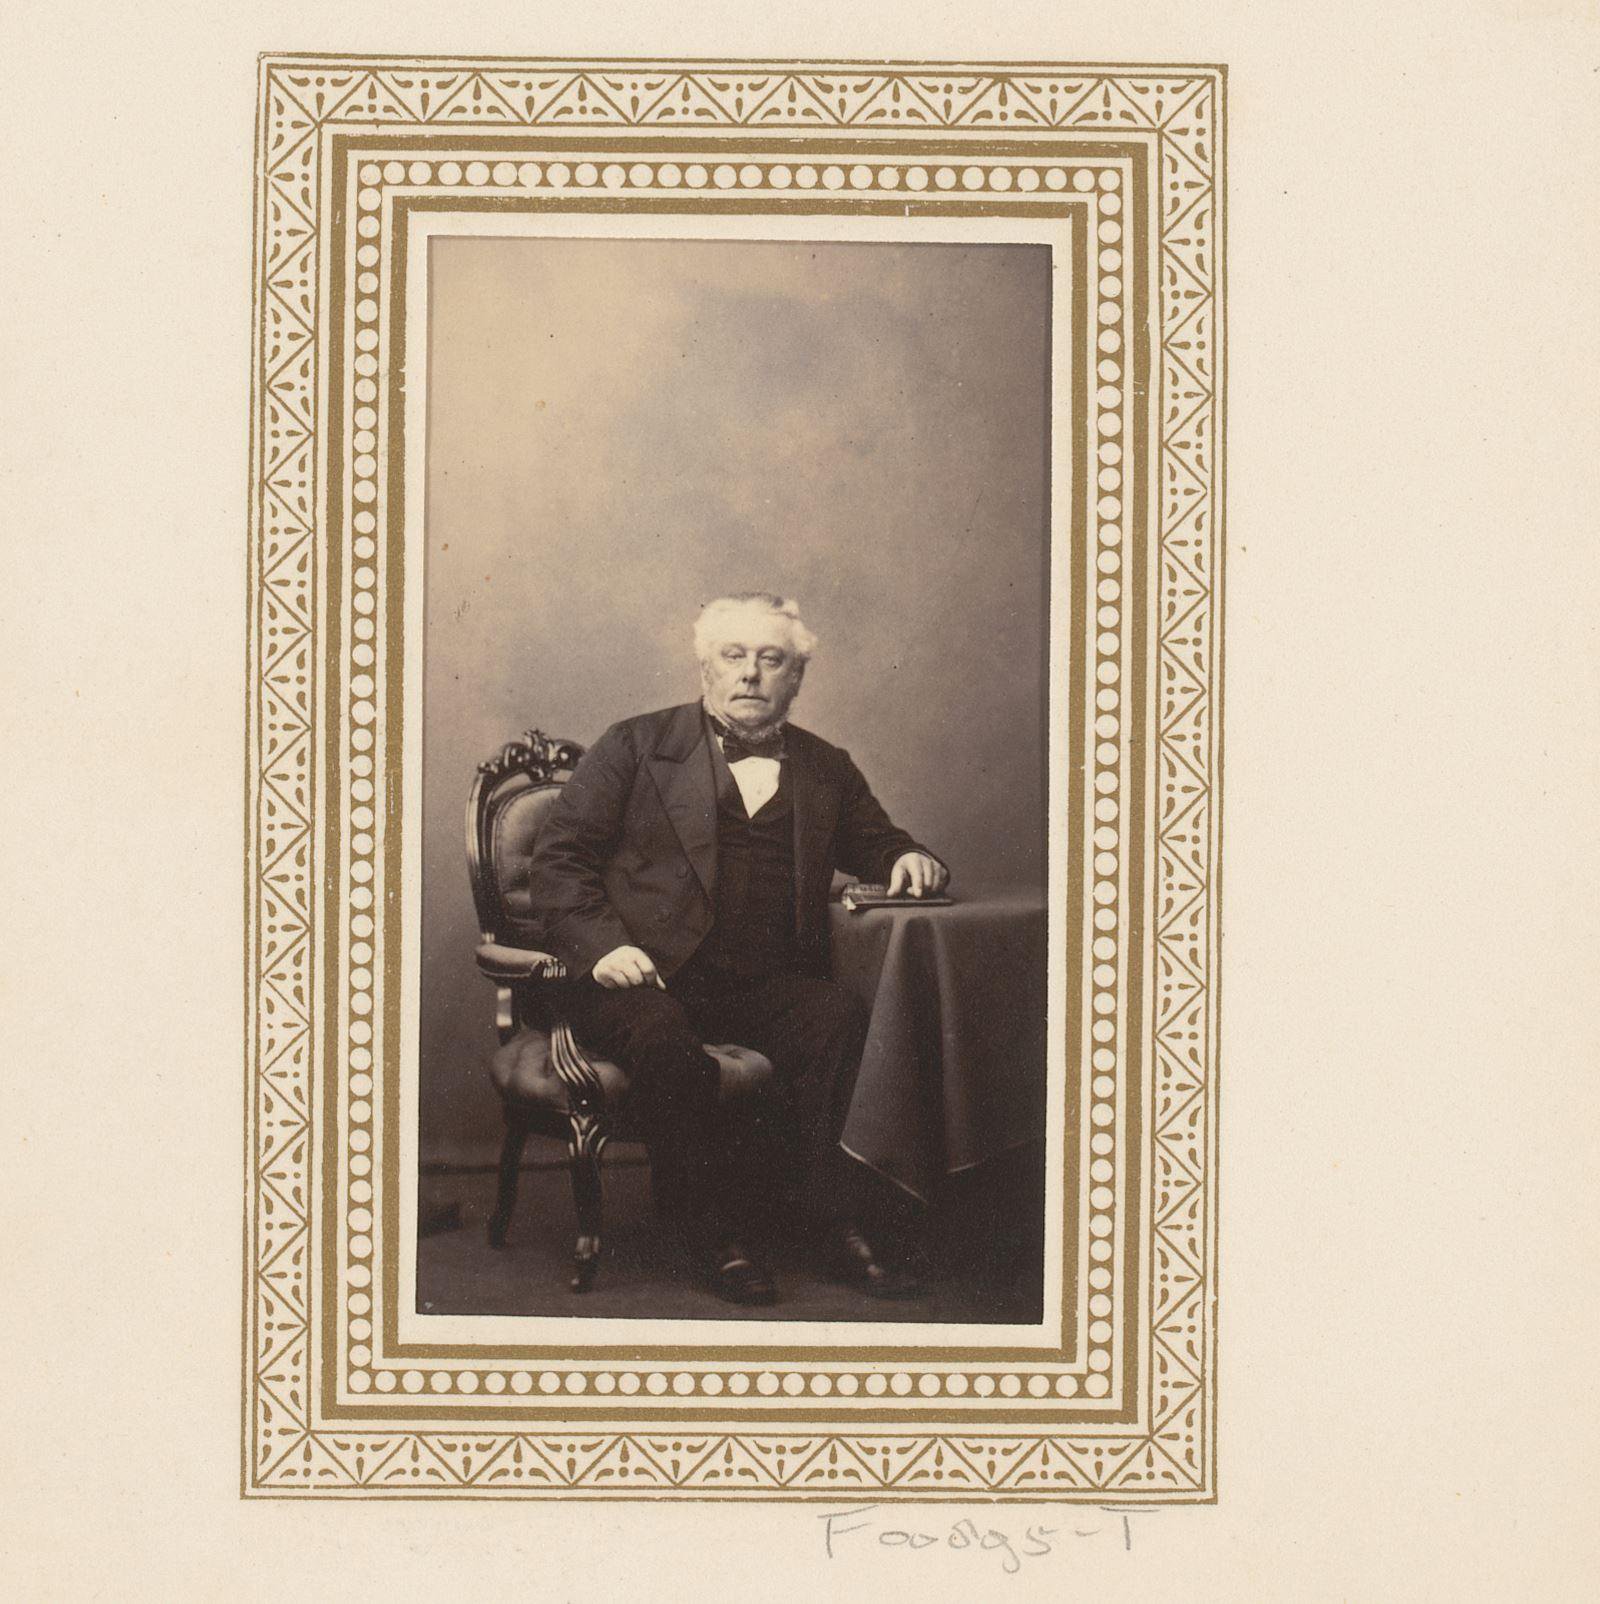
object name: album leaf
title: Portret een man, zittend aan een tafel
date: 1855-1865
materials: cardboard, photographic support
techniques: albumen print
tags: sitting figure, adult man, historical persons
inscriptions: inscription: ‘Hennah & Kent/ 108, King's Road/ Brighton’